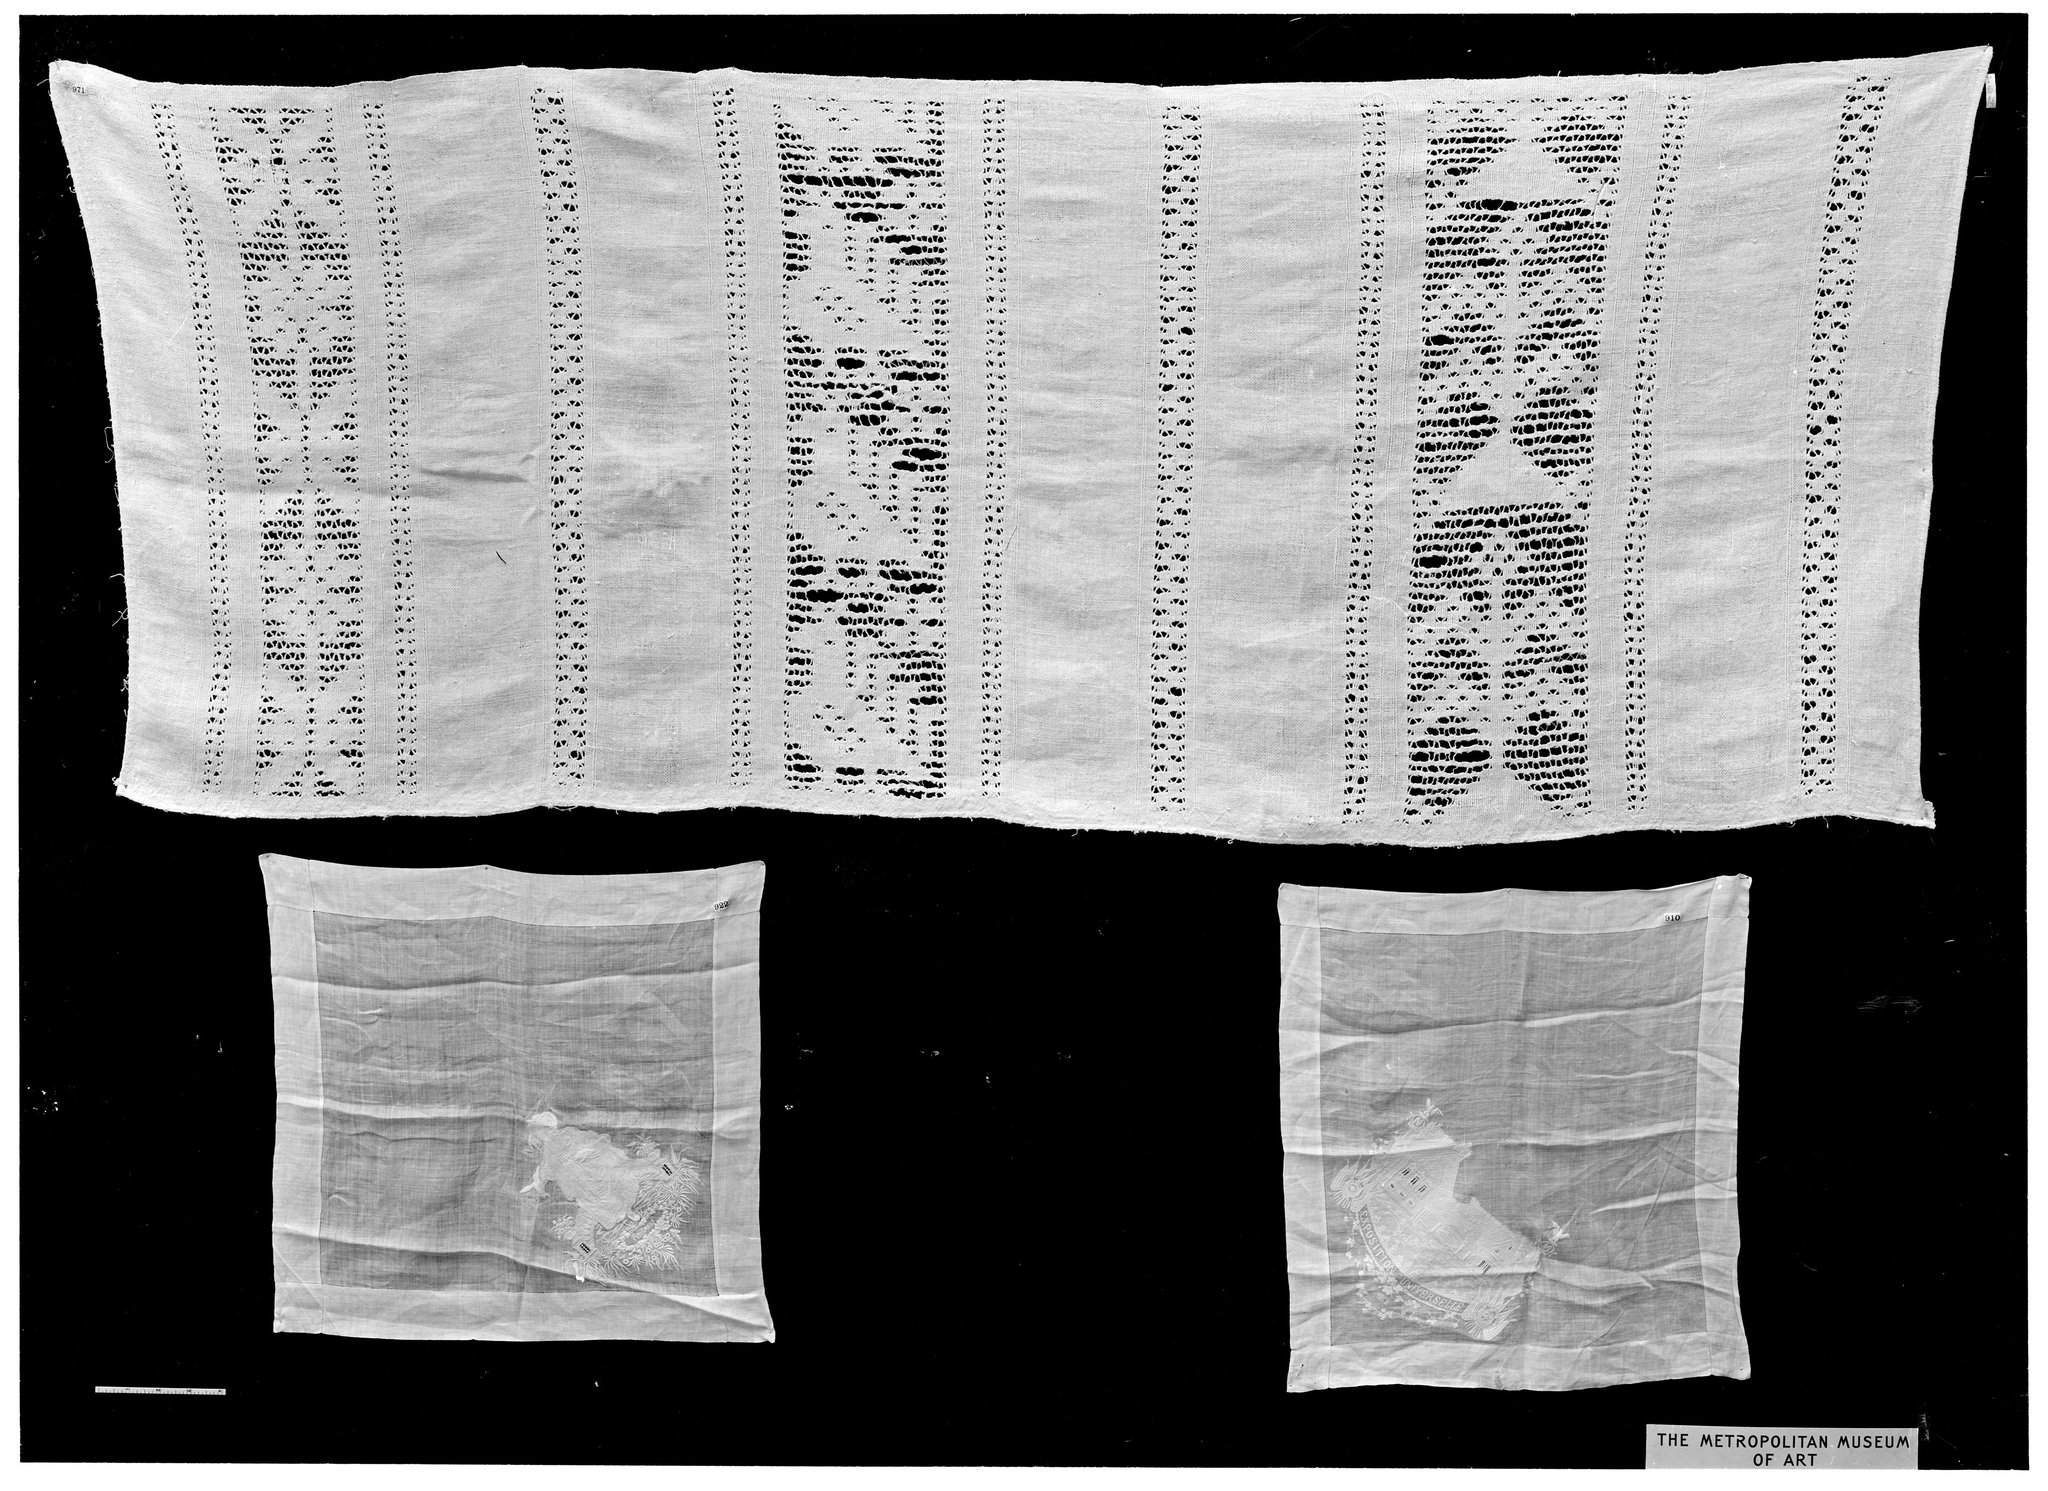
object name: towel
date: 1601-1700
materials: linen